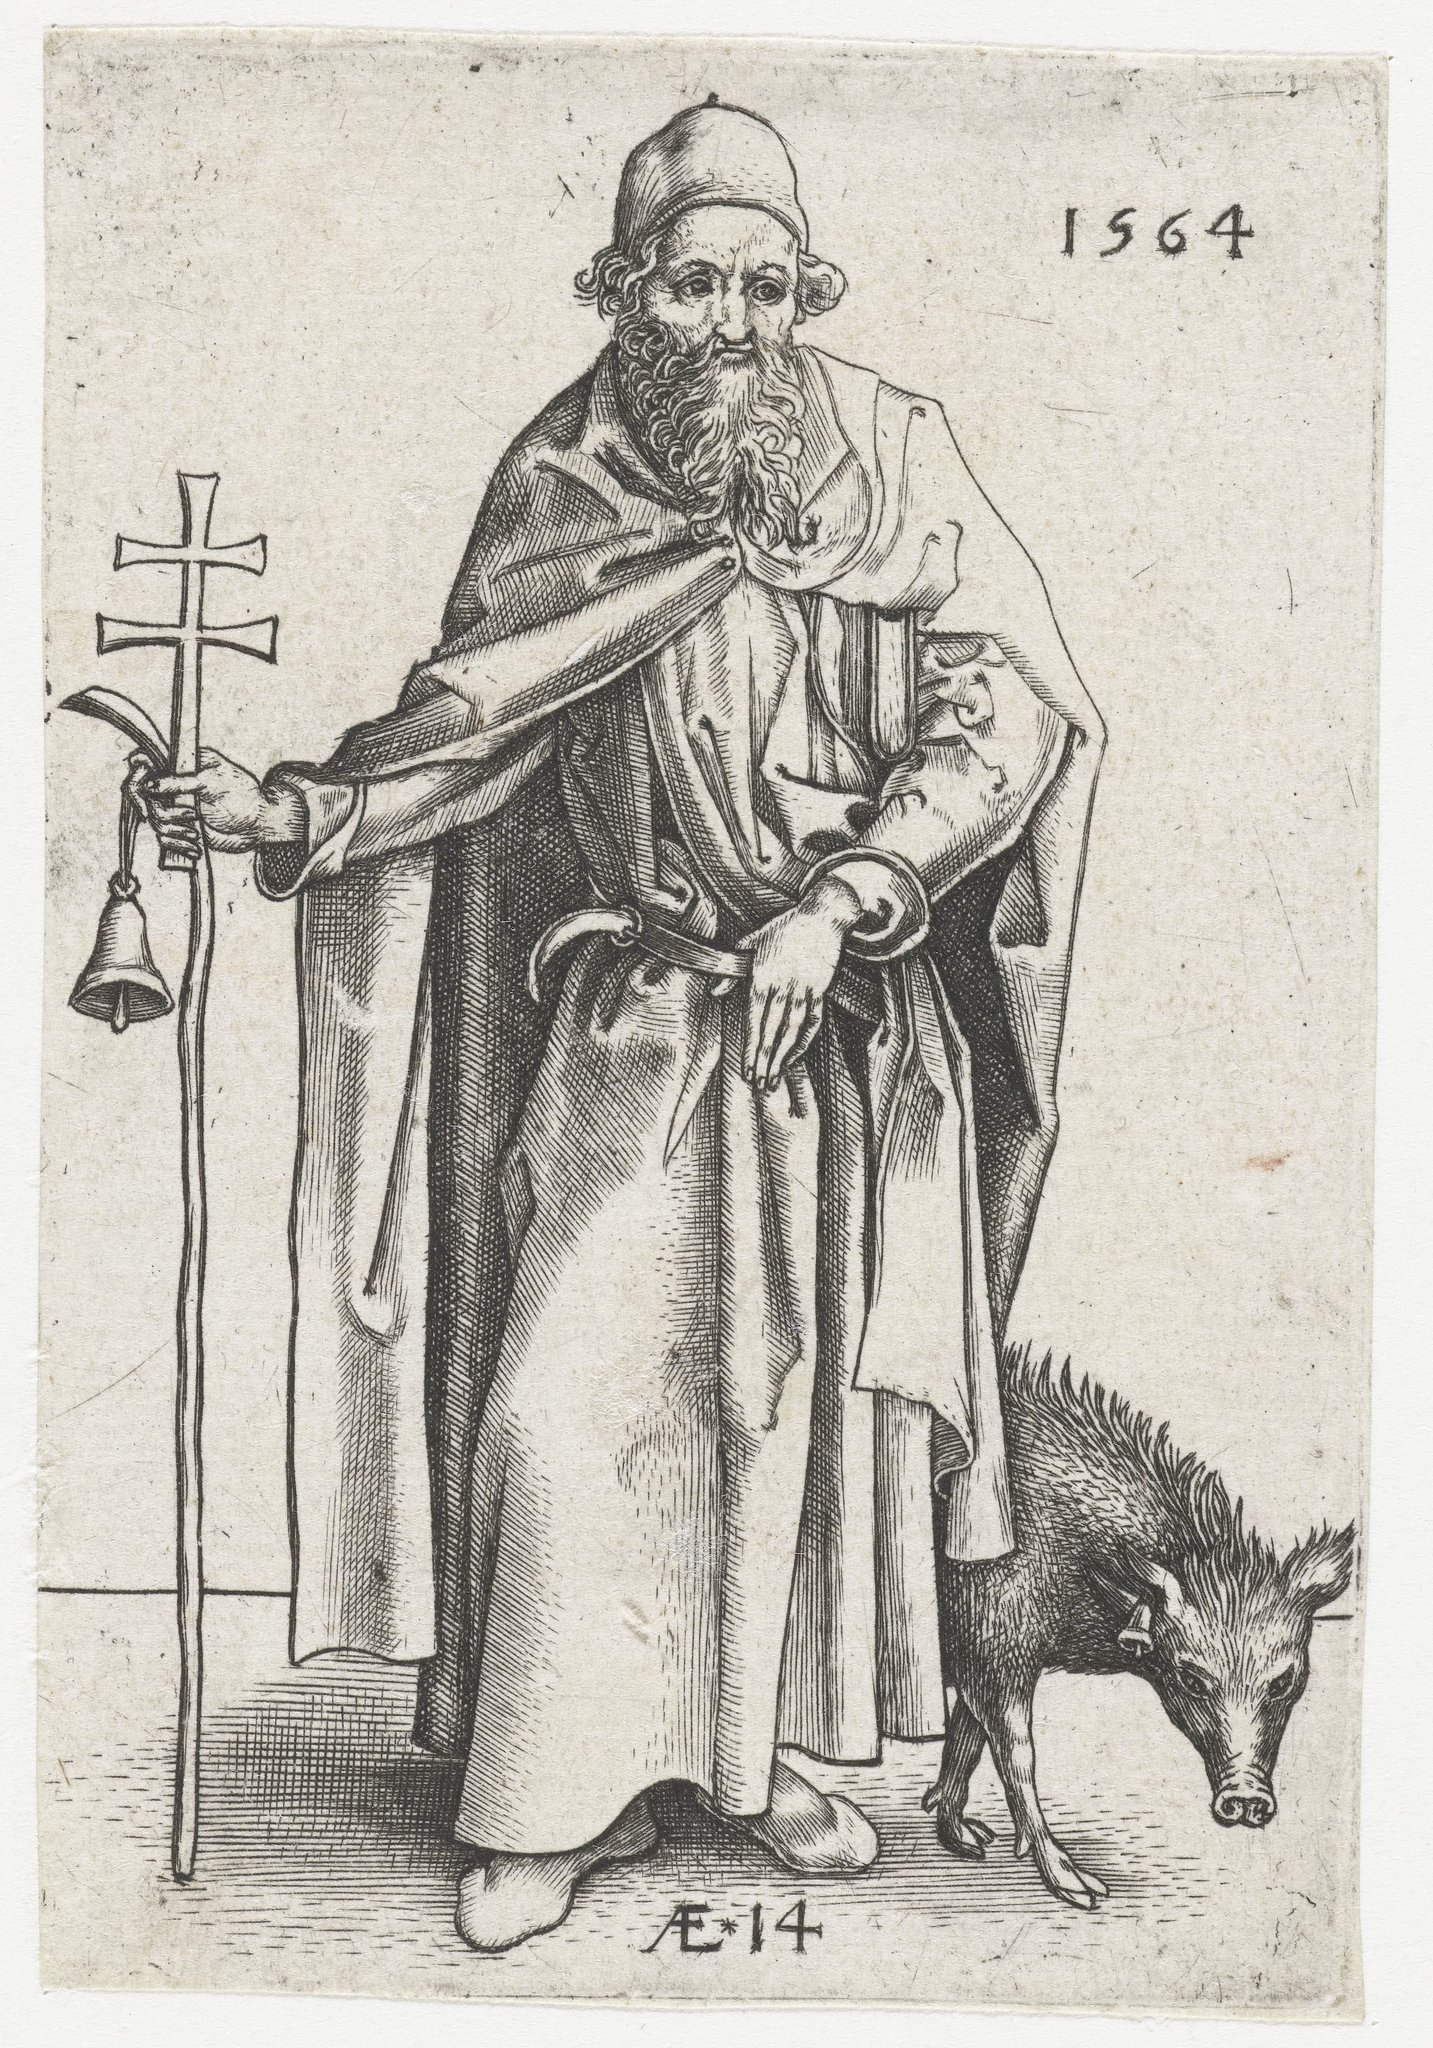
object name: print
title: Heilige Antonius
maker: hieronymus wierix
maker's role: draughtsman, print maker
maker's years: 1553-1619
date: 1564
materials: paper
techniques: engraving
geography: antwerp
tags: the hermit antony abbot (antonius abbas) of egypt, also called the great; possible attributes: bell, book, t-shaped staff, flames, pig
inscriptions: collector's mark: Lugt 240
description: De Heilige Antonius met een staf, een kruis en een bel in de hand en een varken bij zijn voeten. Onderin de voorstelling staat 'AE * 14'.